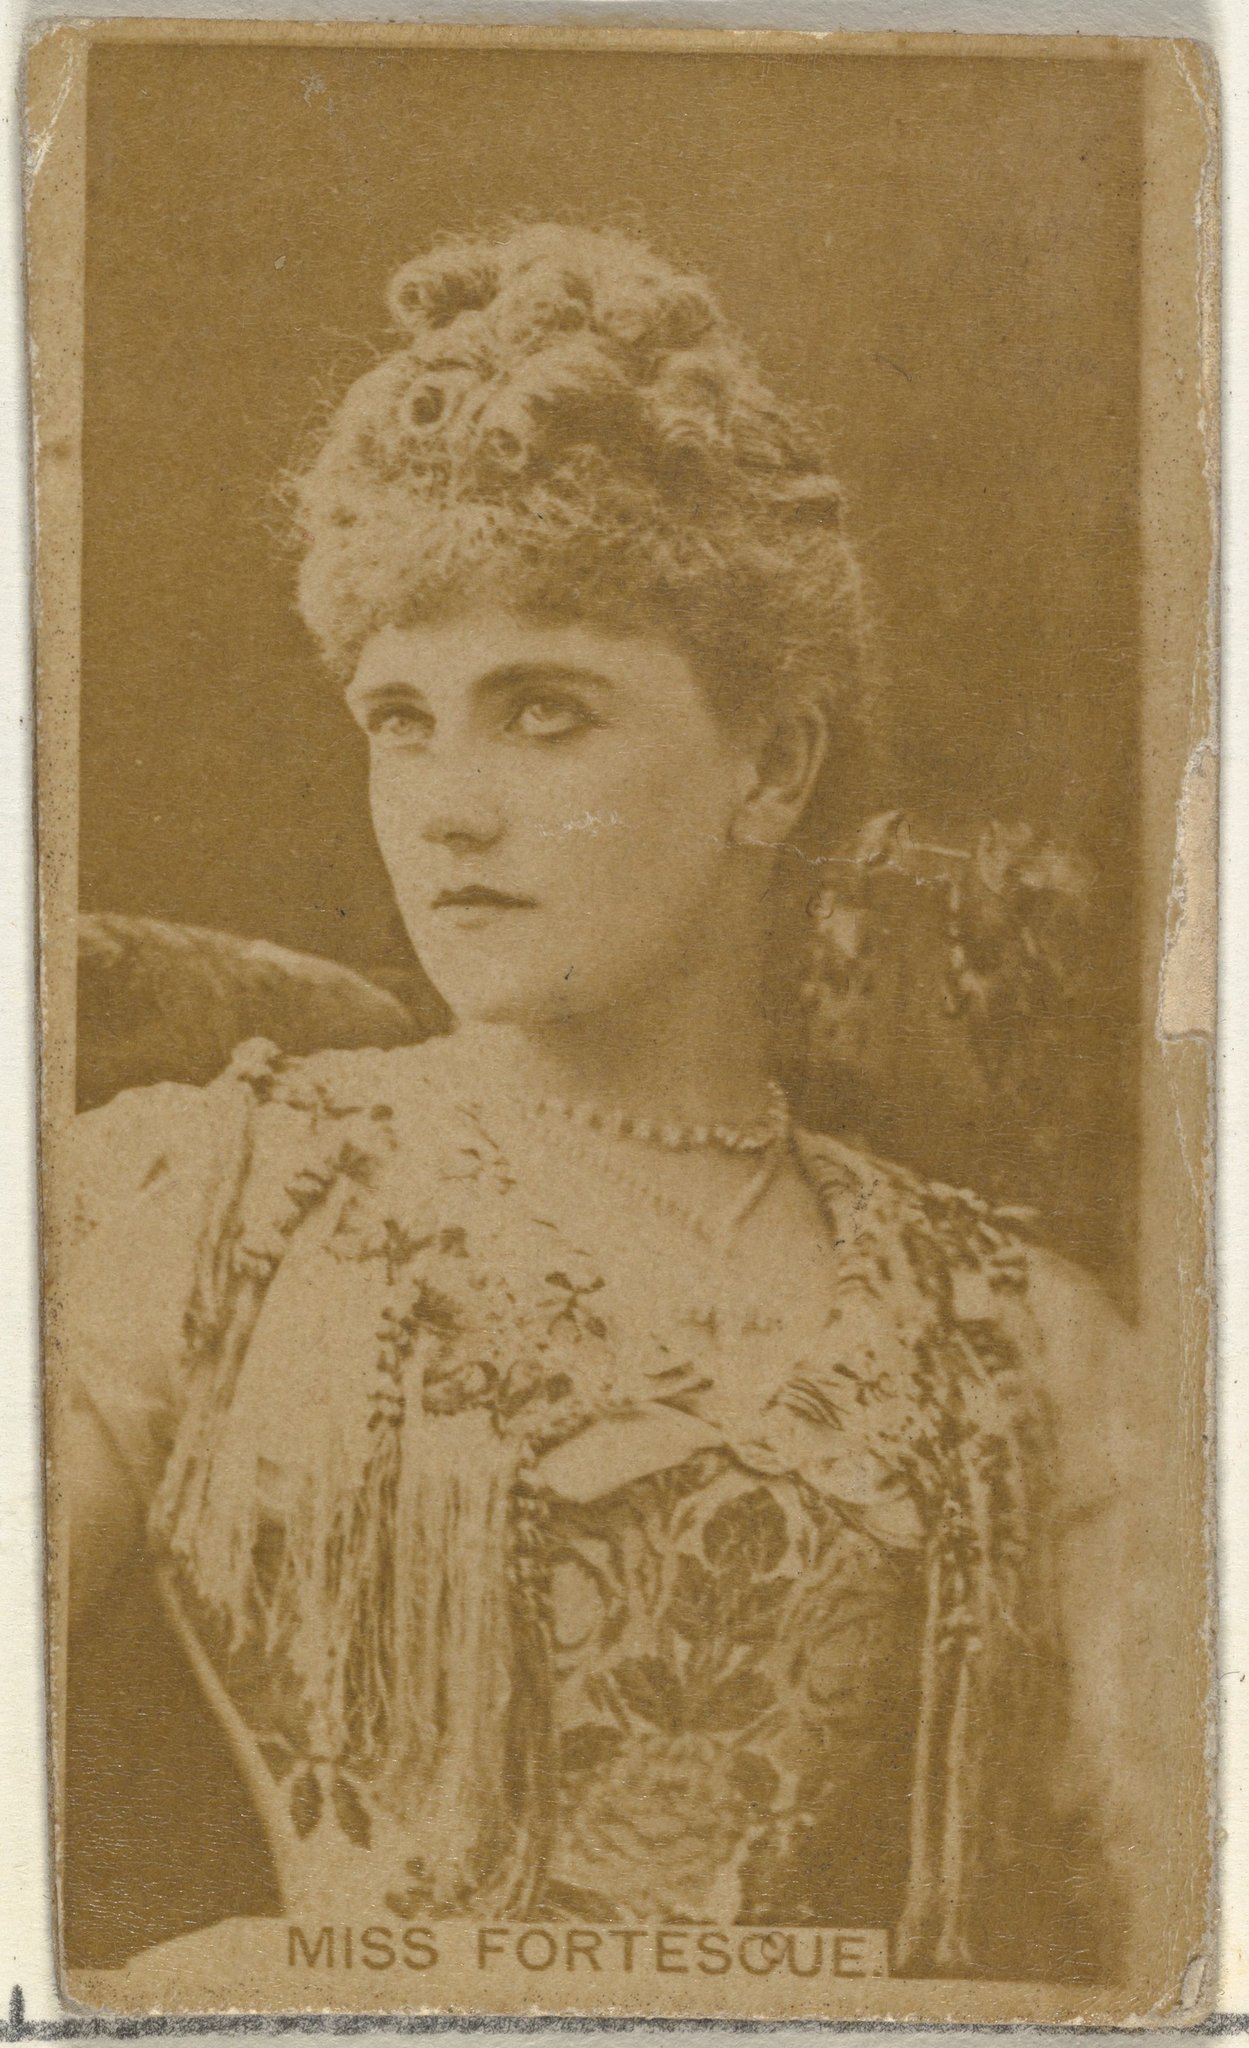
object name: photograph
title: Miss Fortescue, from the Actors and Actresses series (N145-8) issued by Duke Sons & Co. to promote Duke Cigarettes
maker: w. duke, sons & co.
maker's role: publisher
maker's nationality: american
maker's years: 1870-1920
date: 1891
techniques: albumen silver print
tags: portraits,women,actresses